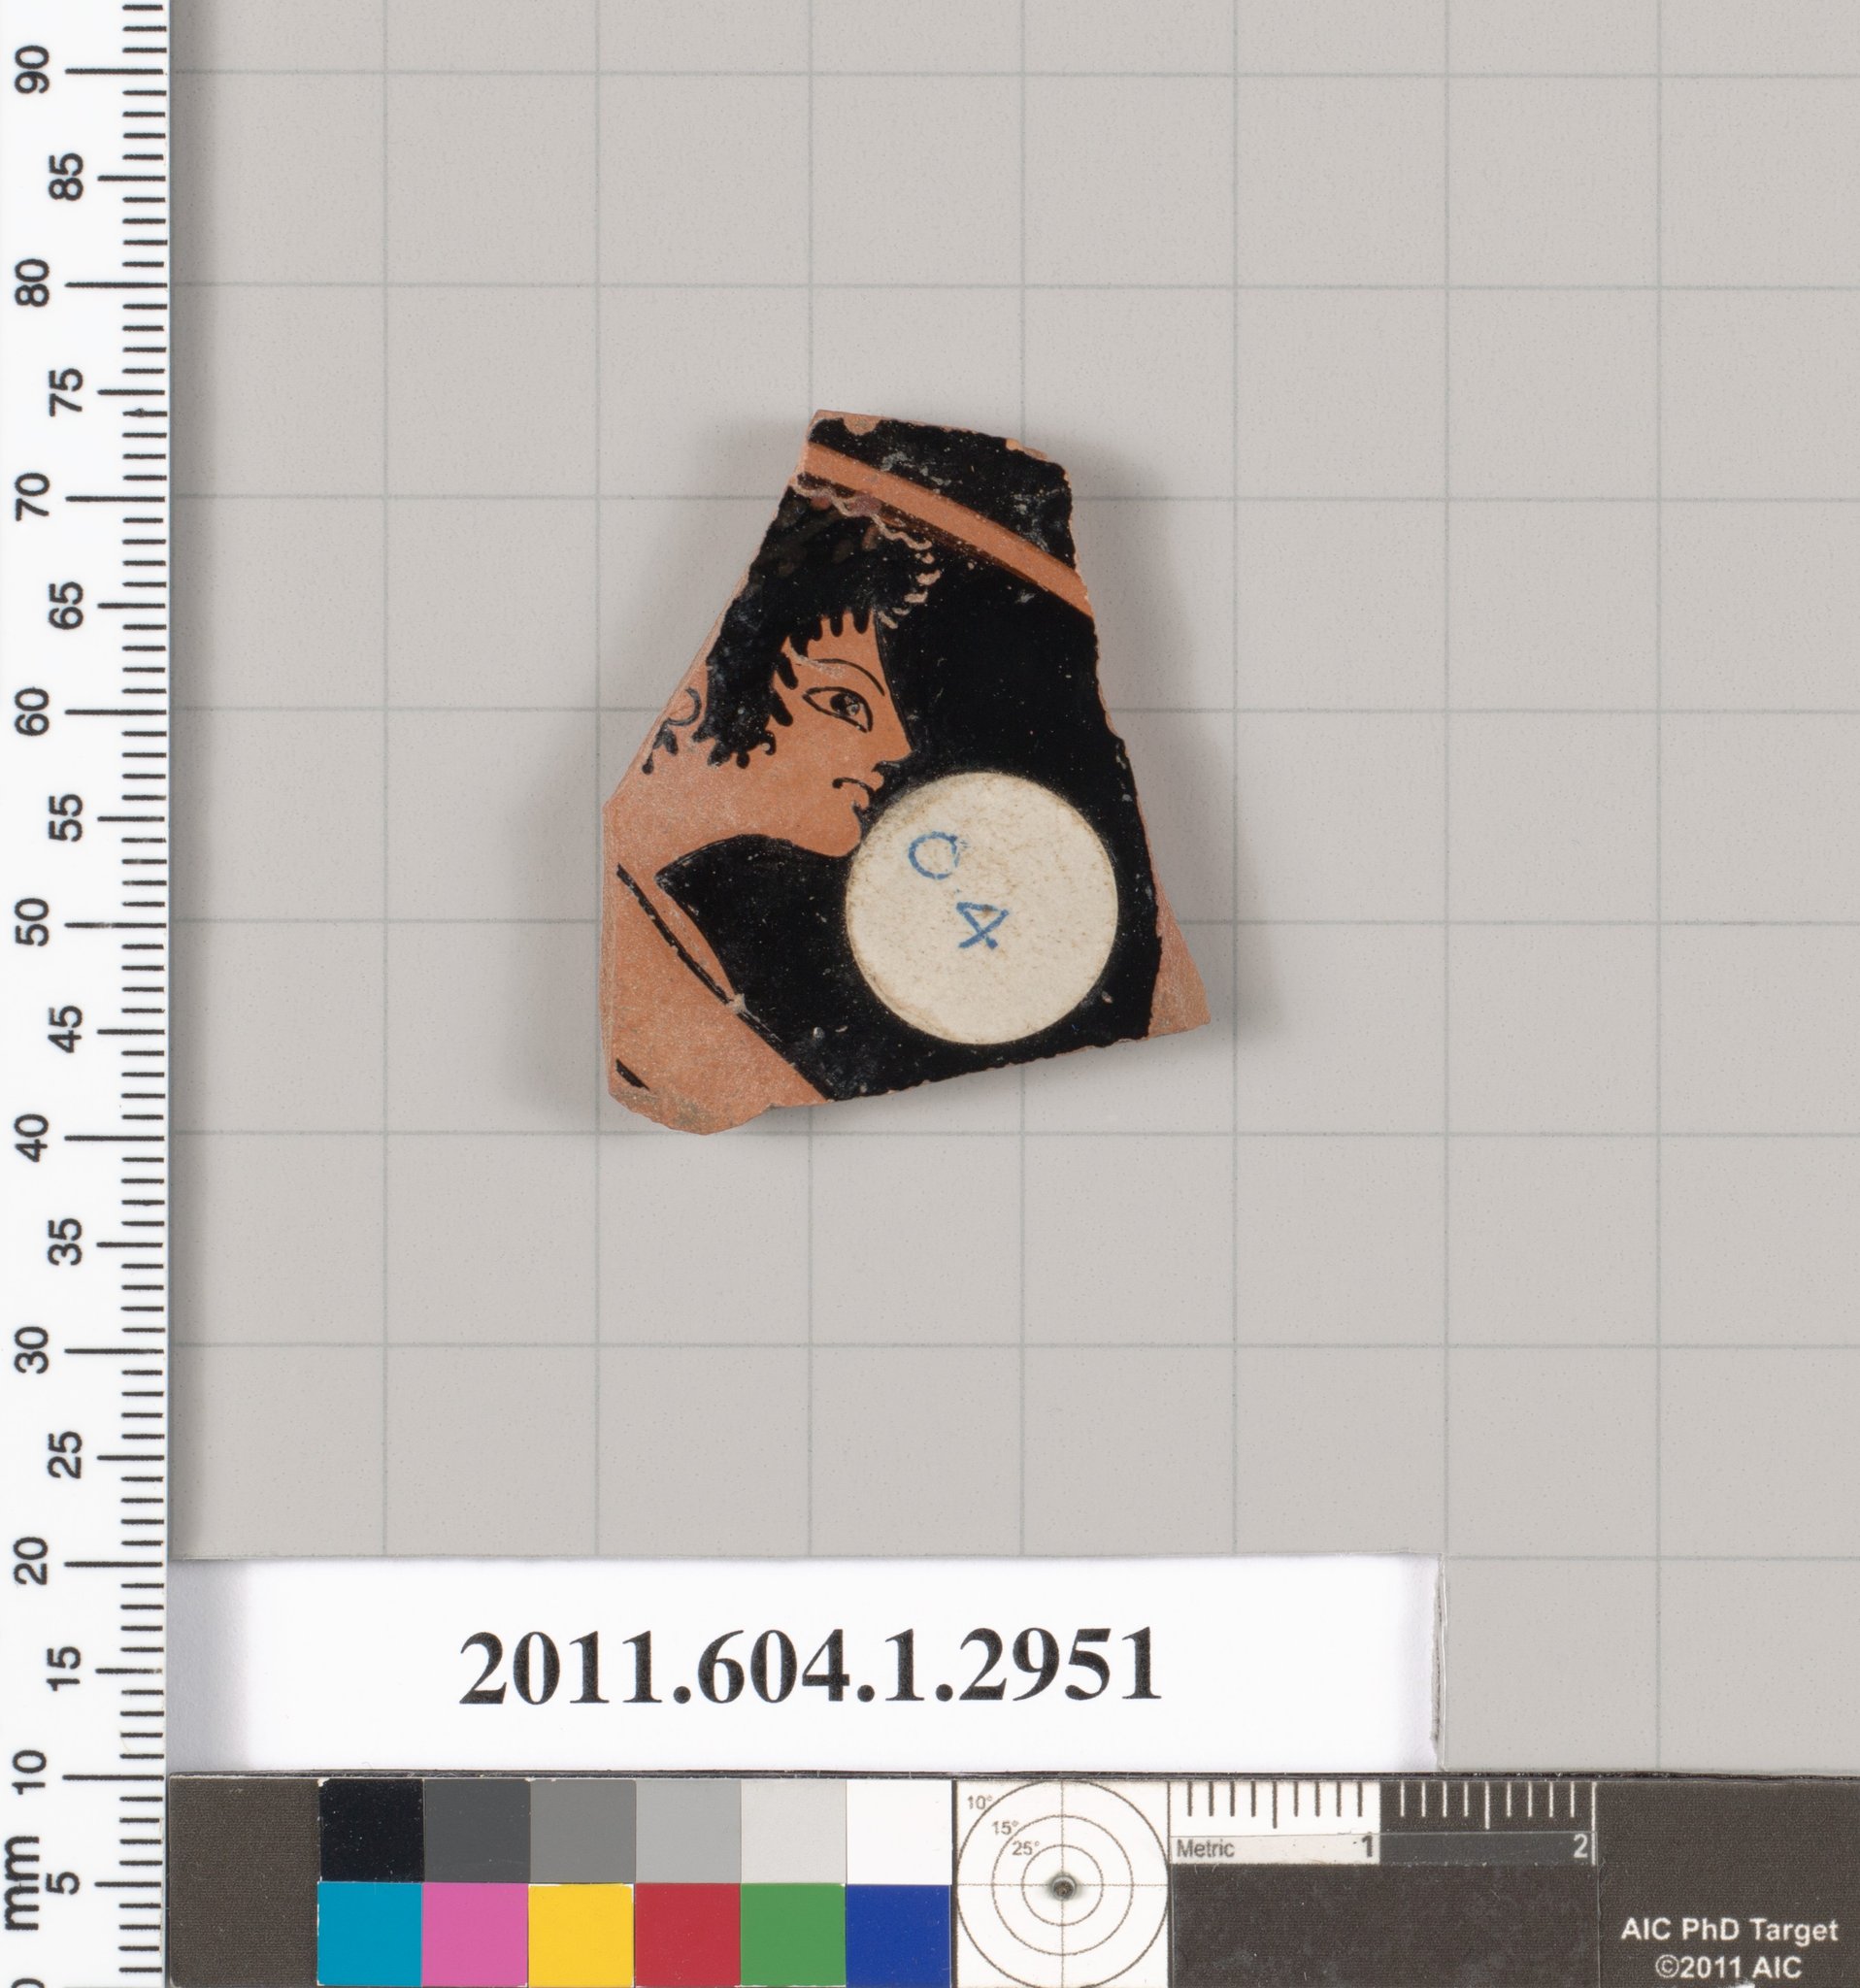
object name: kylix fragment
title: Terracotta fragment of a kylix (drinking cup)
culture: greek, attic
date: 520-500 BCE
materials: terracotta